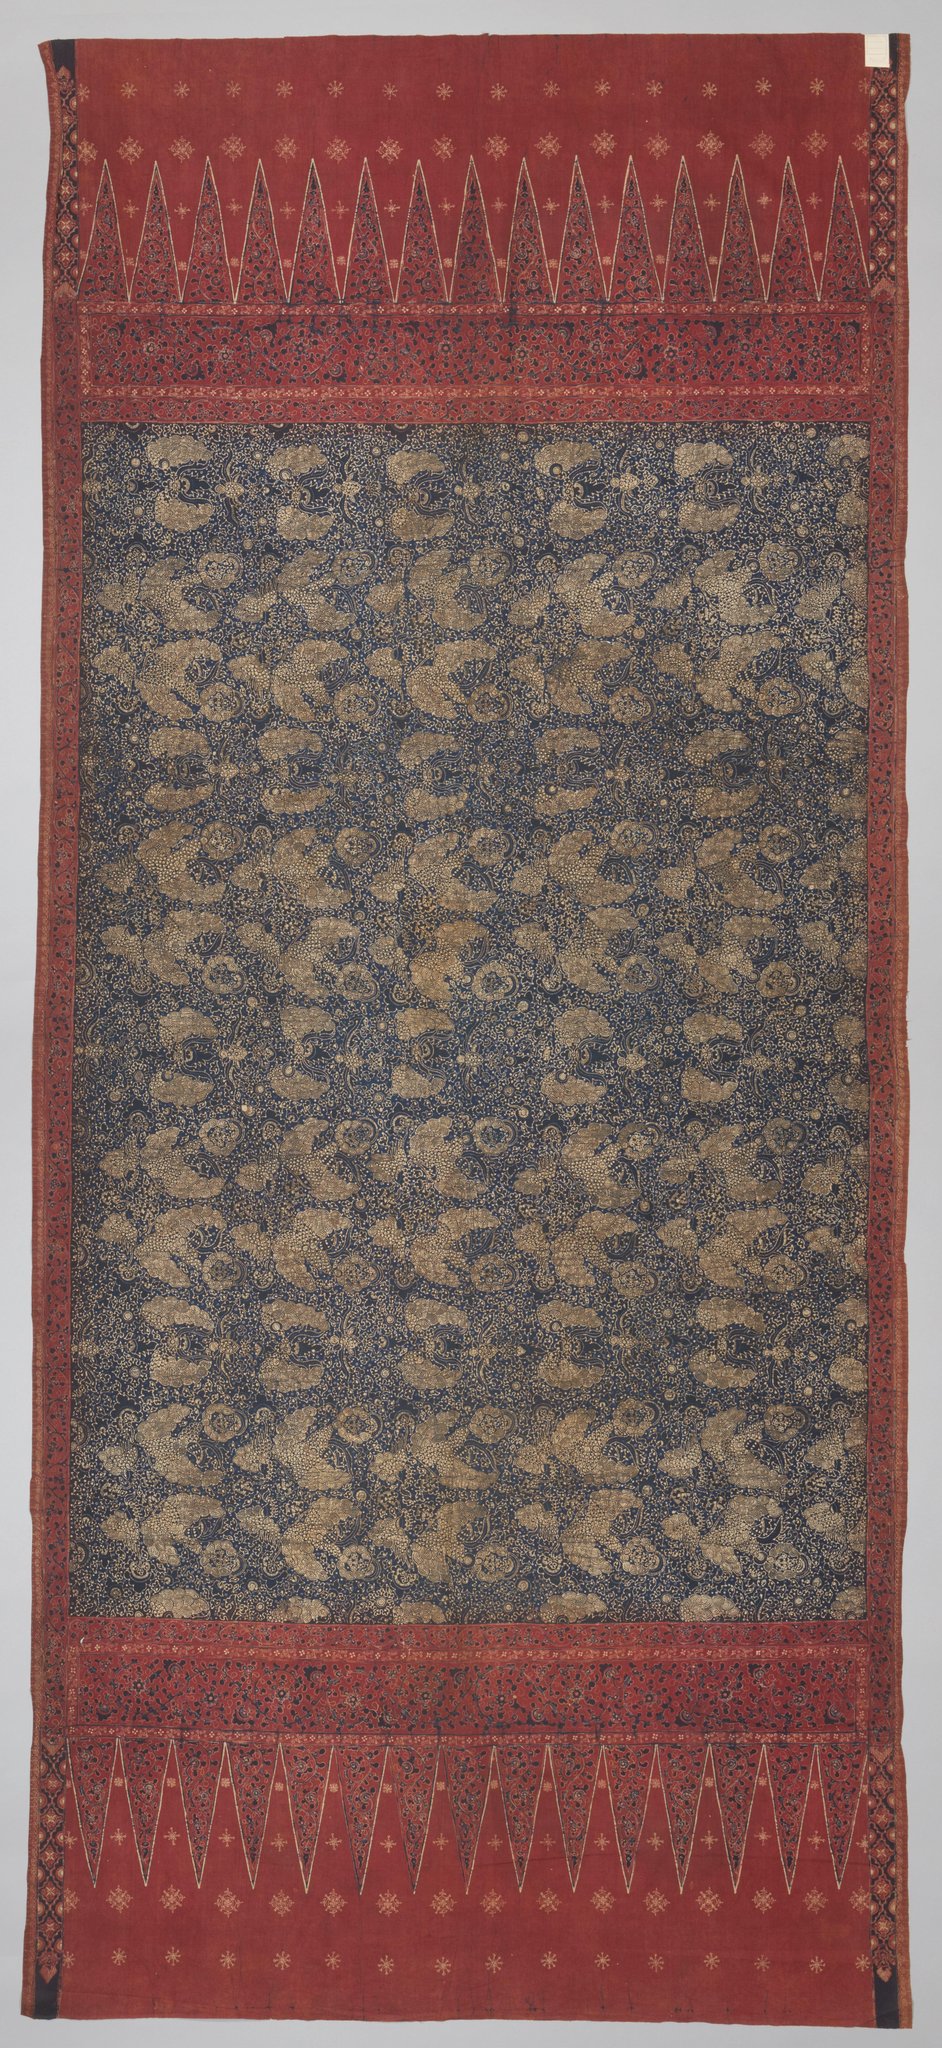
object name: heupdoek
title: Cloth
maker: Anonymous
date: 1940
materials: cotton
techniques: batik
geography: sumatra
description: The elaborate decoration of this cloth was made using the batik method. The pattern is first drawn on the cloth with melted wax, after which the fabric is dyed. When the wax is subsequently boiled out, the uncoloured pattern remains on the cloth. The processis repeated for each colour. The central panel of this cloth is decorated with flowers, plants and birds.